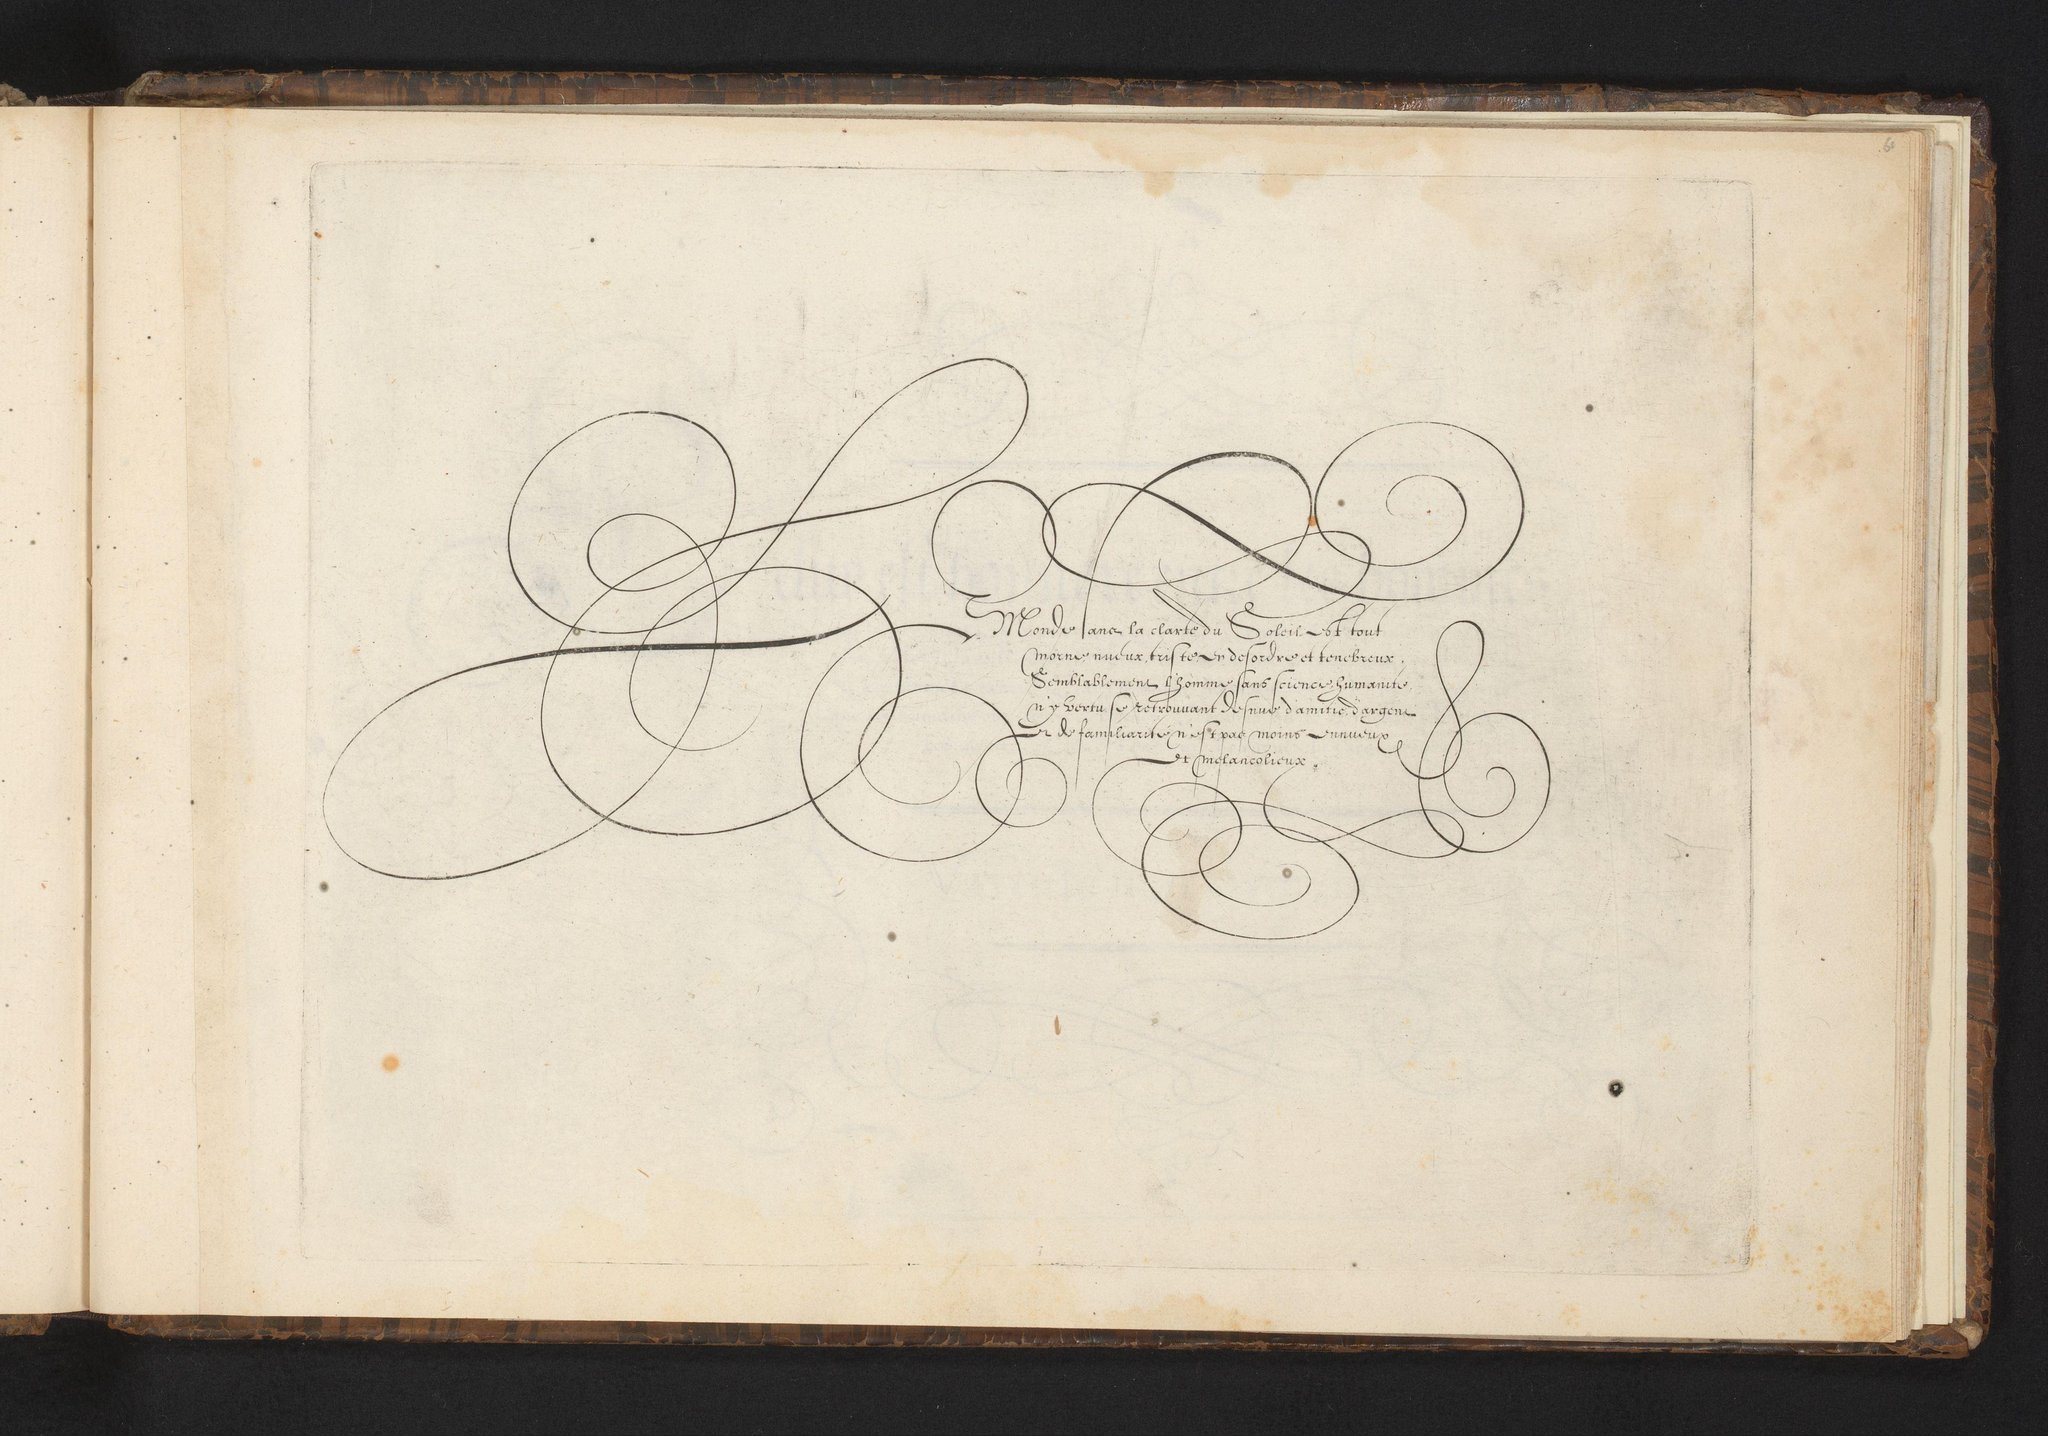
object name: album leaf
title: Grammato-Graphices. In Quo Varia Scripurae Emblemata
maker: cornelis dircksz. boissens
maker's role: draughtsman, print maker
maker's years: 1567-1635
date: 1605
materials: paper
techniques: engraving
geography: amsterdam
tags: calligraphy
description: Schrijfvoorbeeld met zes regels tekst in het Frans: Le Monde sans la clarte du Soleil ... De prent maakt deel uit van een album.